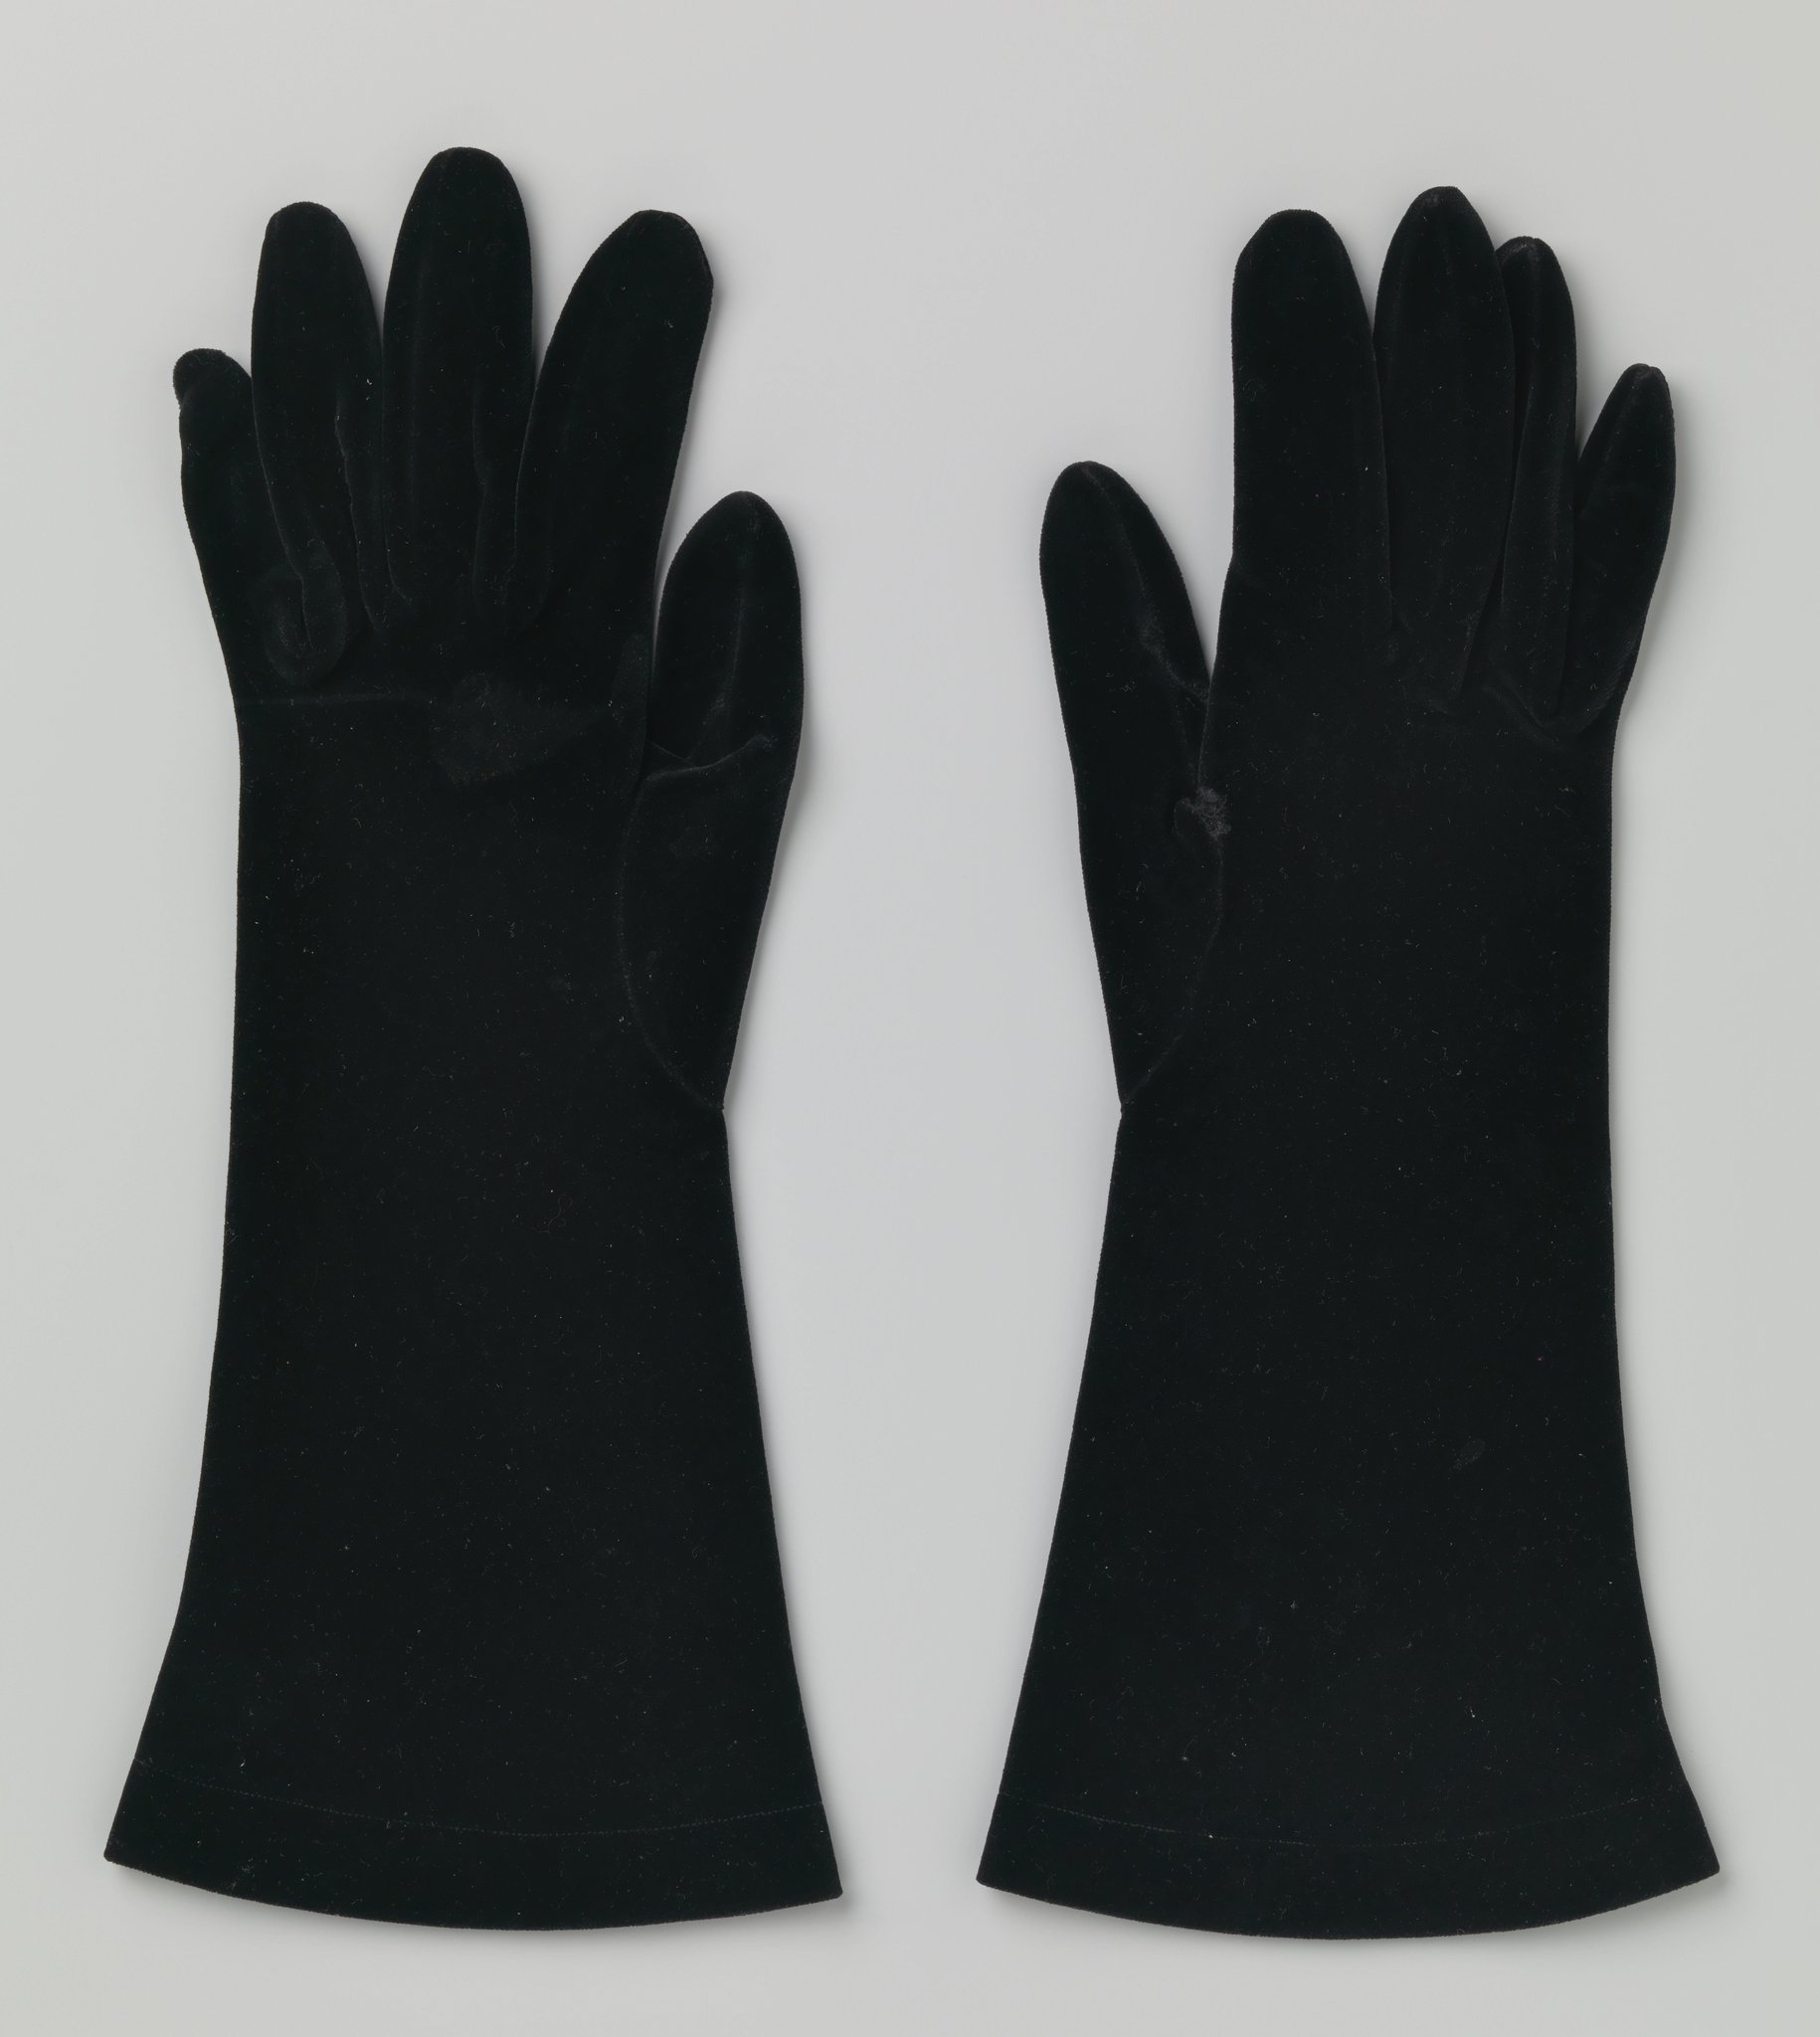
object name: glove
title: Handschoen van zwarte velours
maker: Anonymous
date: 1910-1925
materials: velvet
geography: western europe